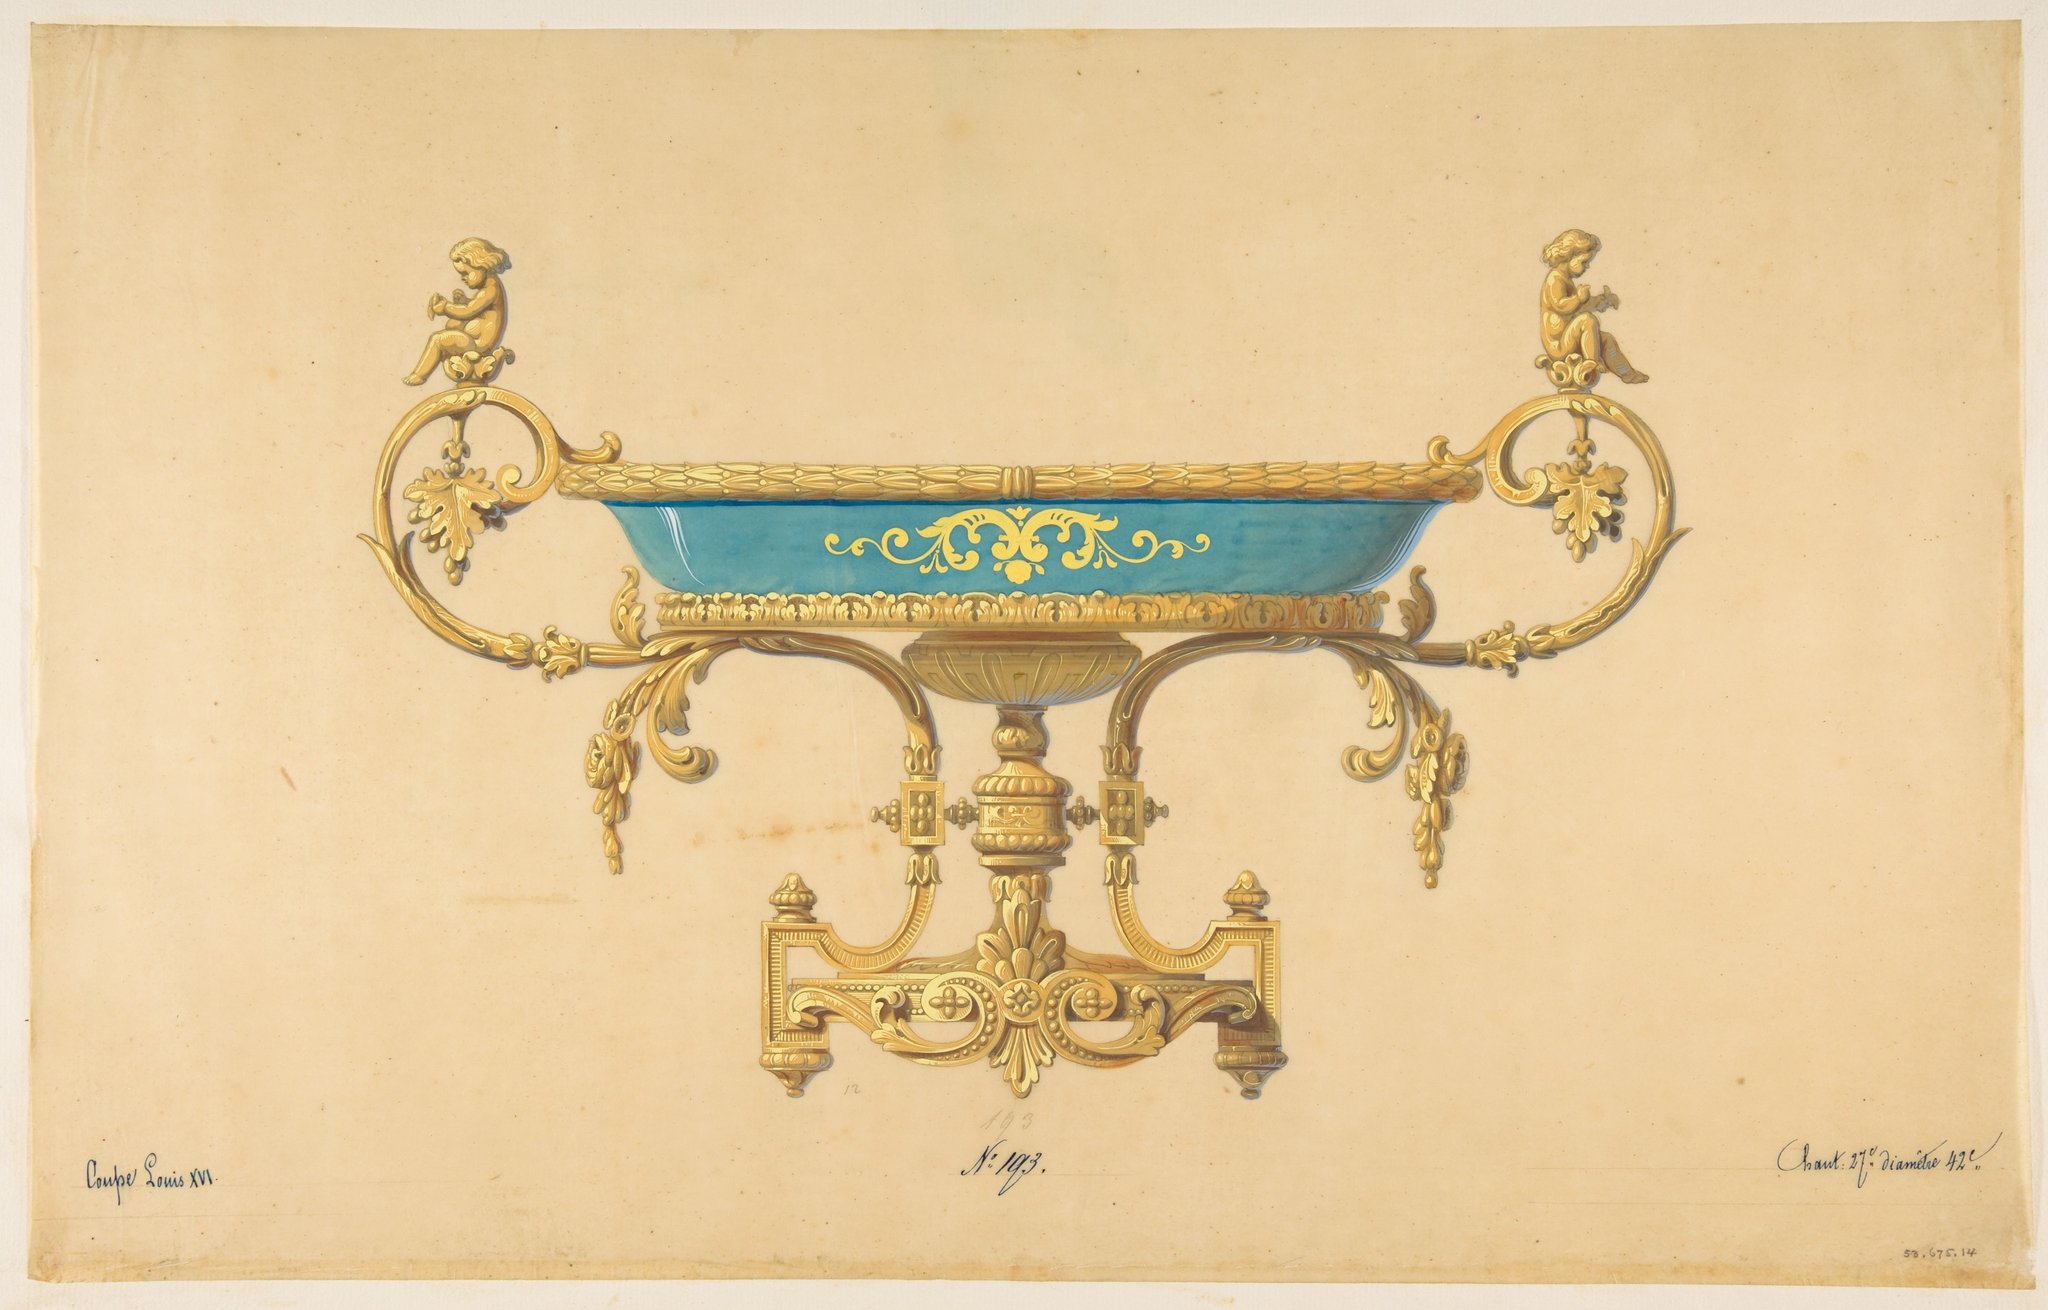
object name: drawing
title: Design for a Compotier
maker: anonymous, french, 19th century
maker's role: artist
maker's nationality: french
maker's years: 1800-1900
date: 1801-1900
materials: gouache, graphite, watercolor